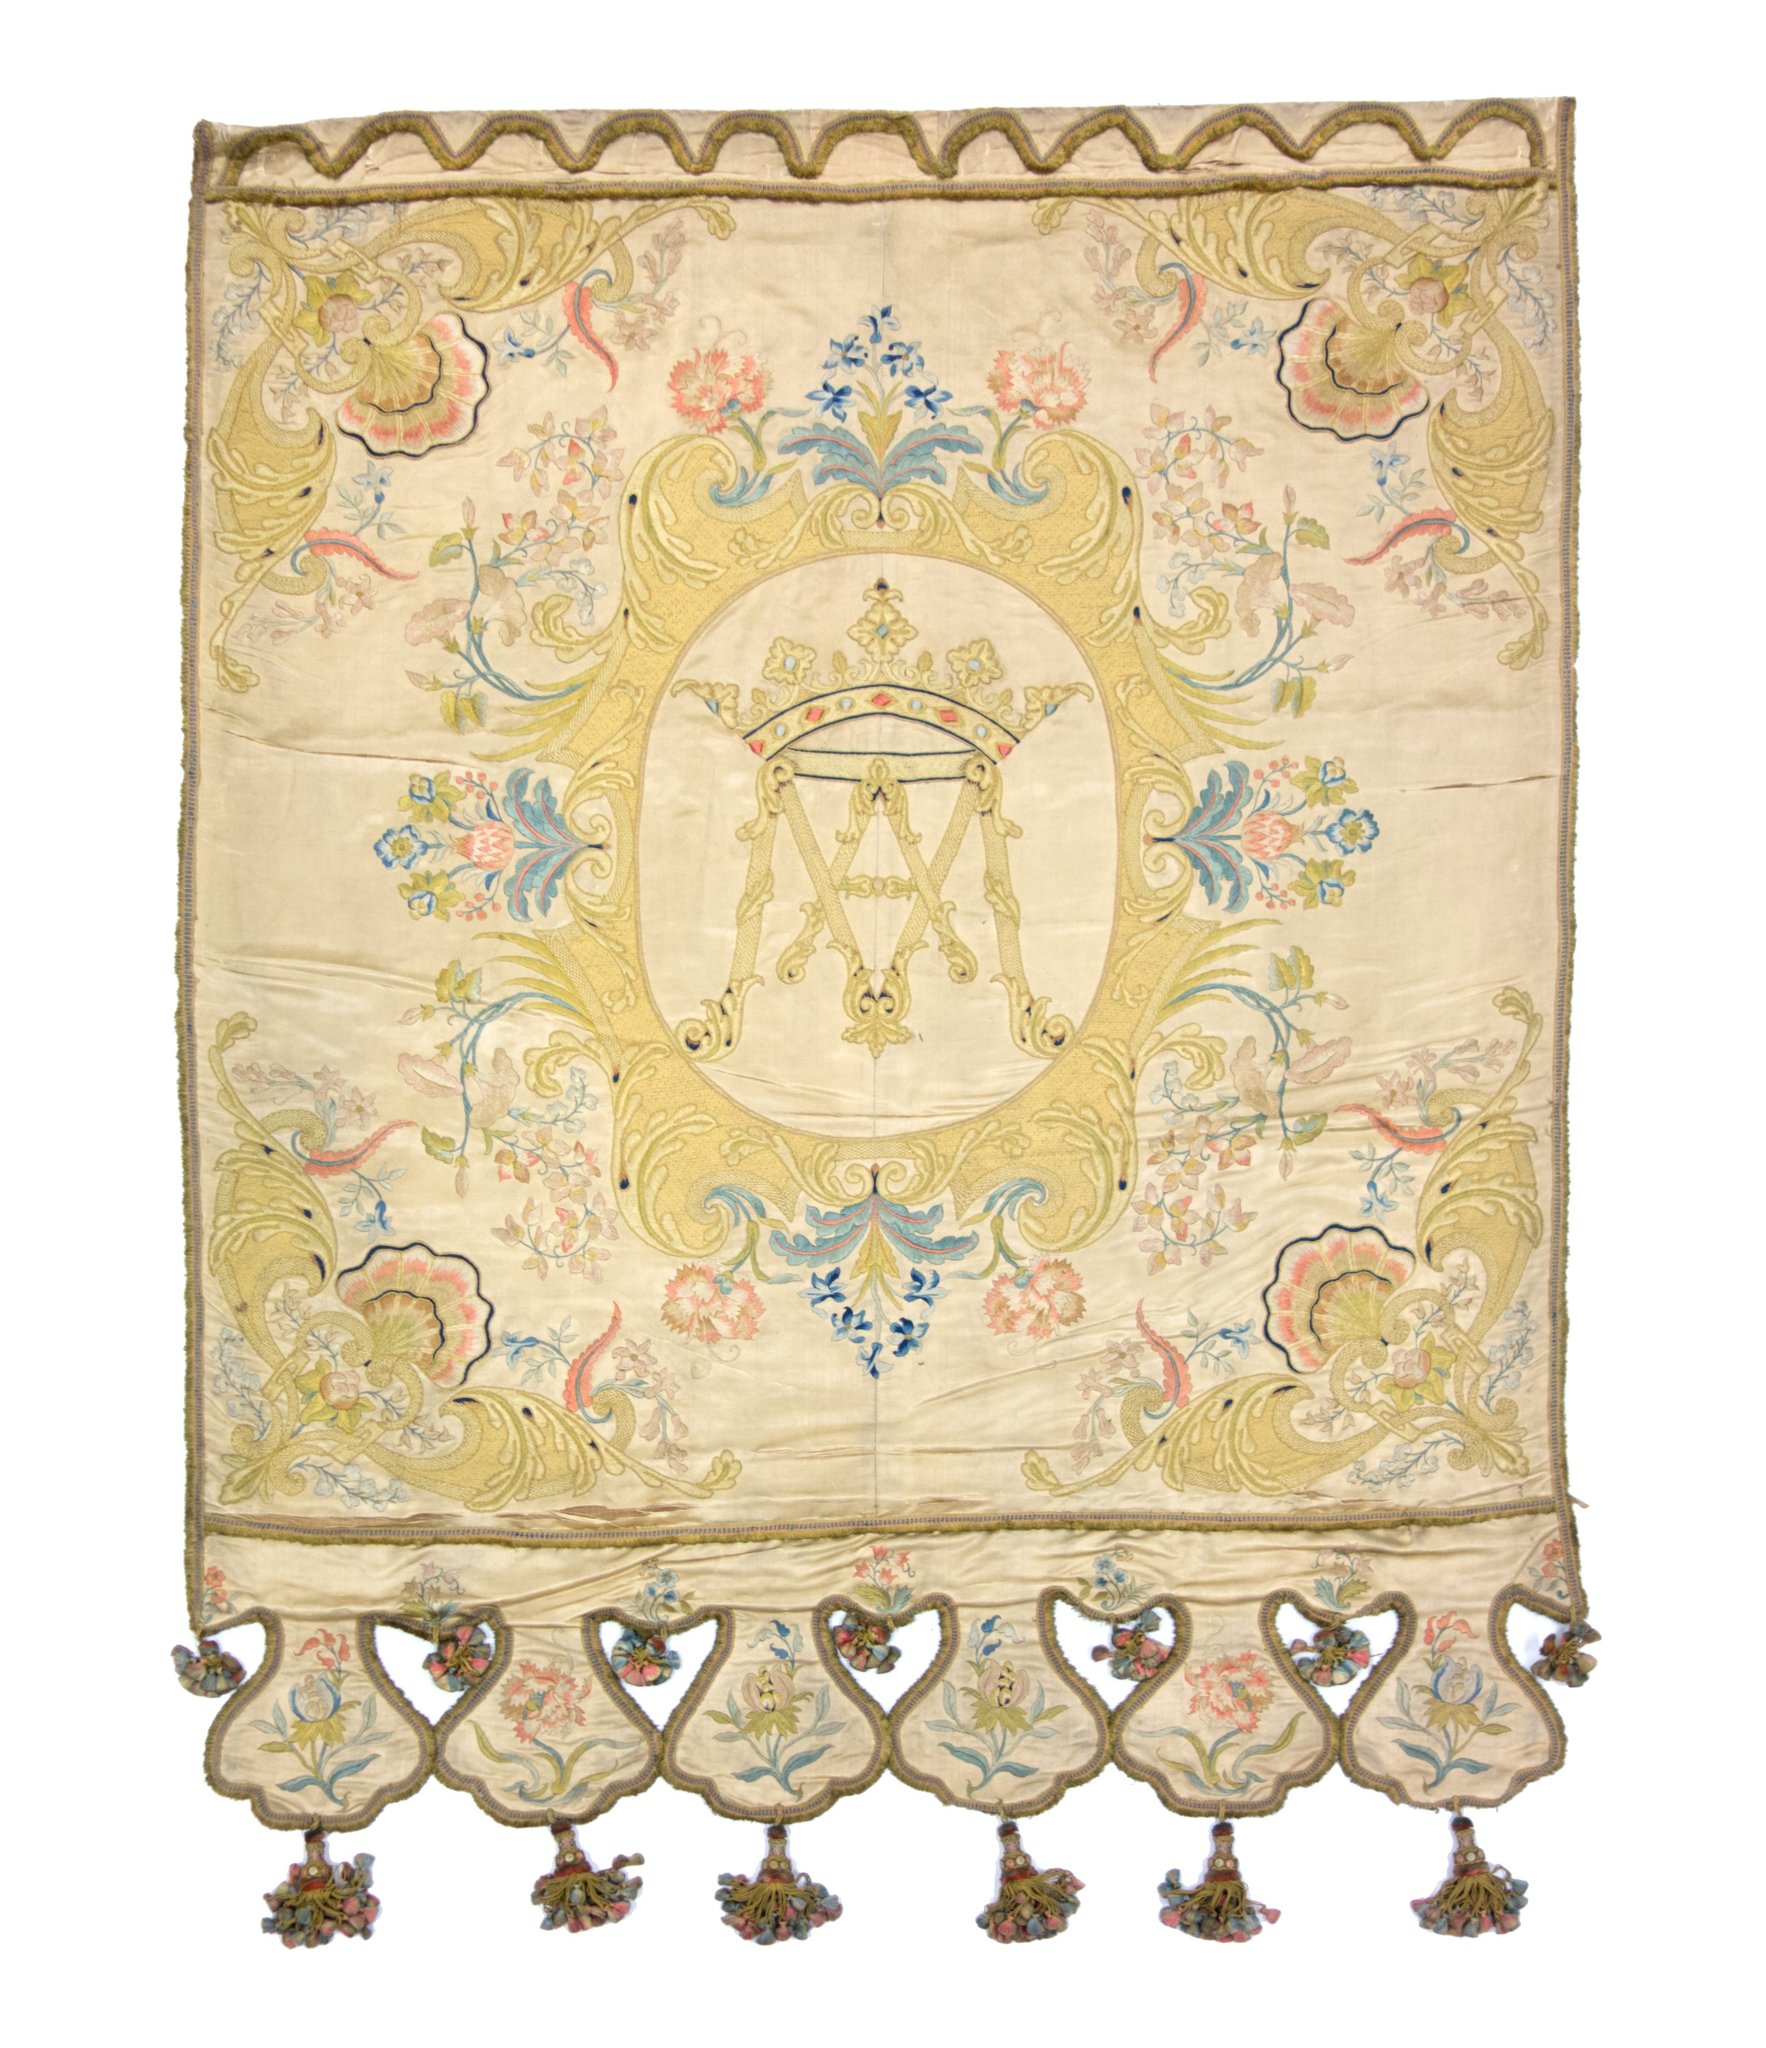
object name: banner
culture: spanish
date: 1801-1833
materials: gold, textile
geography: spain